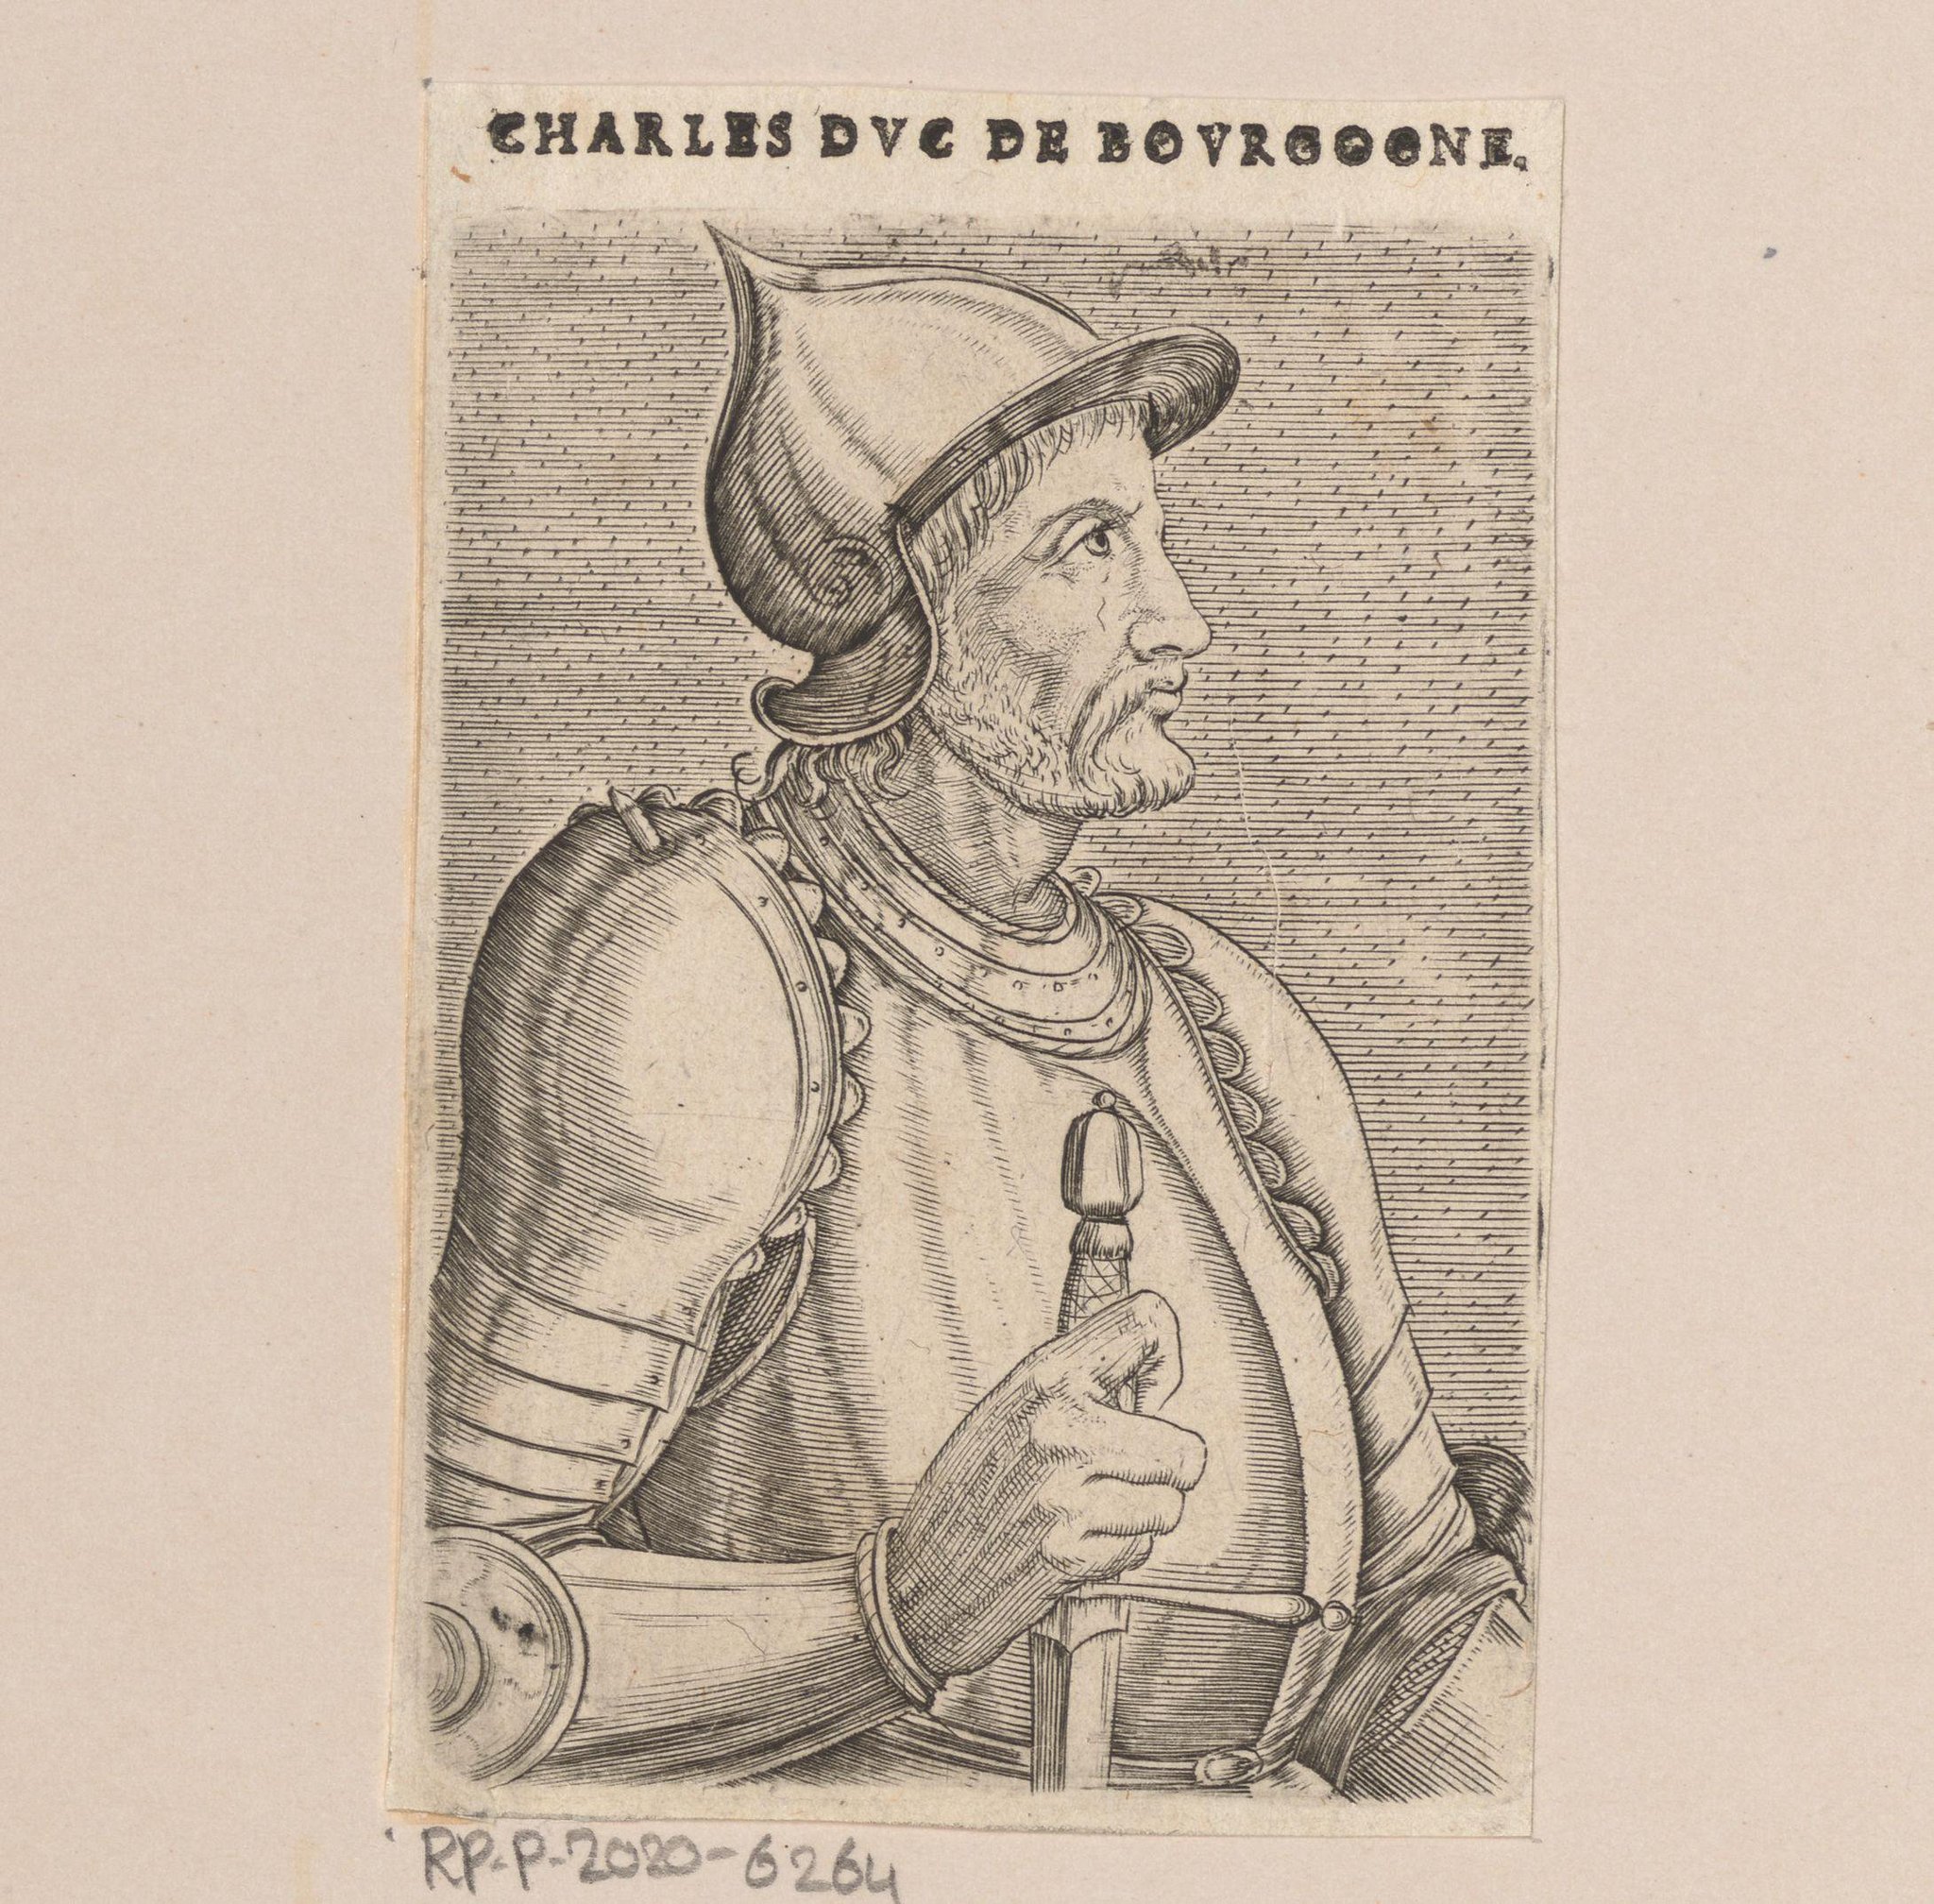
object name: print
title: Portret van Karel de Stoute, hertog van Bourgondië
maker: Anonymous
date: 1600-1699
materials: paper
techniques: engraving, letterpress printing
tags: earl, charles the bold (duke of burgundy), historical persons